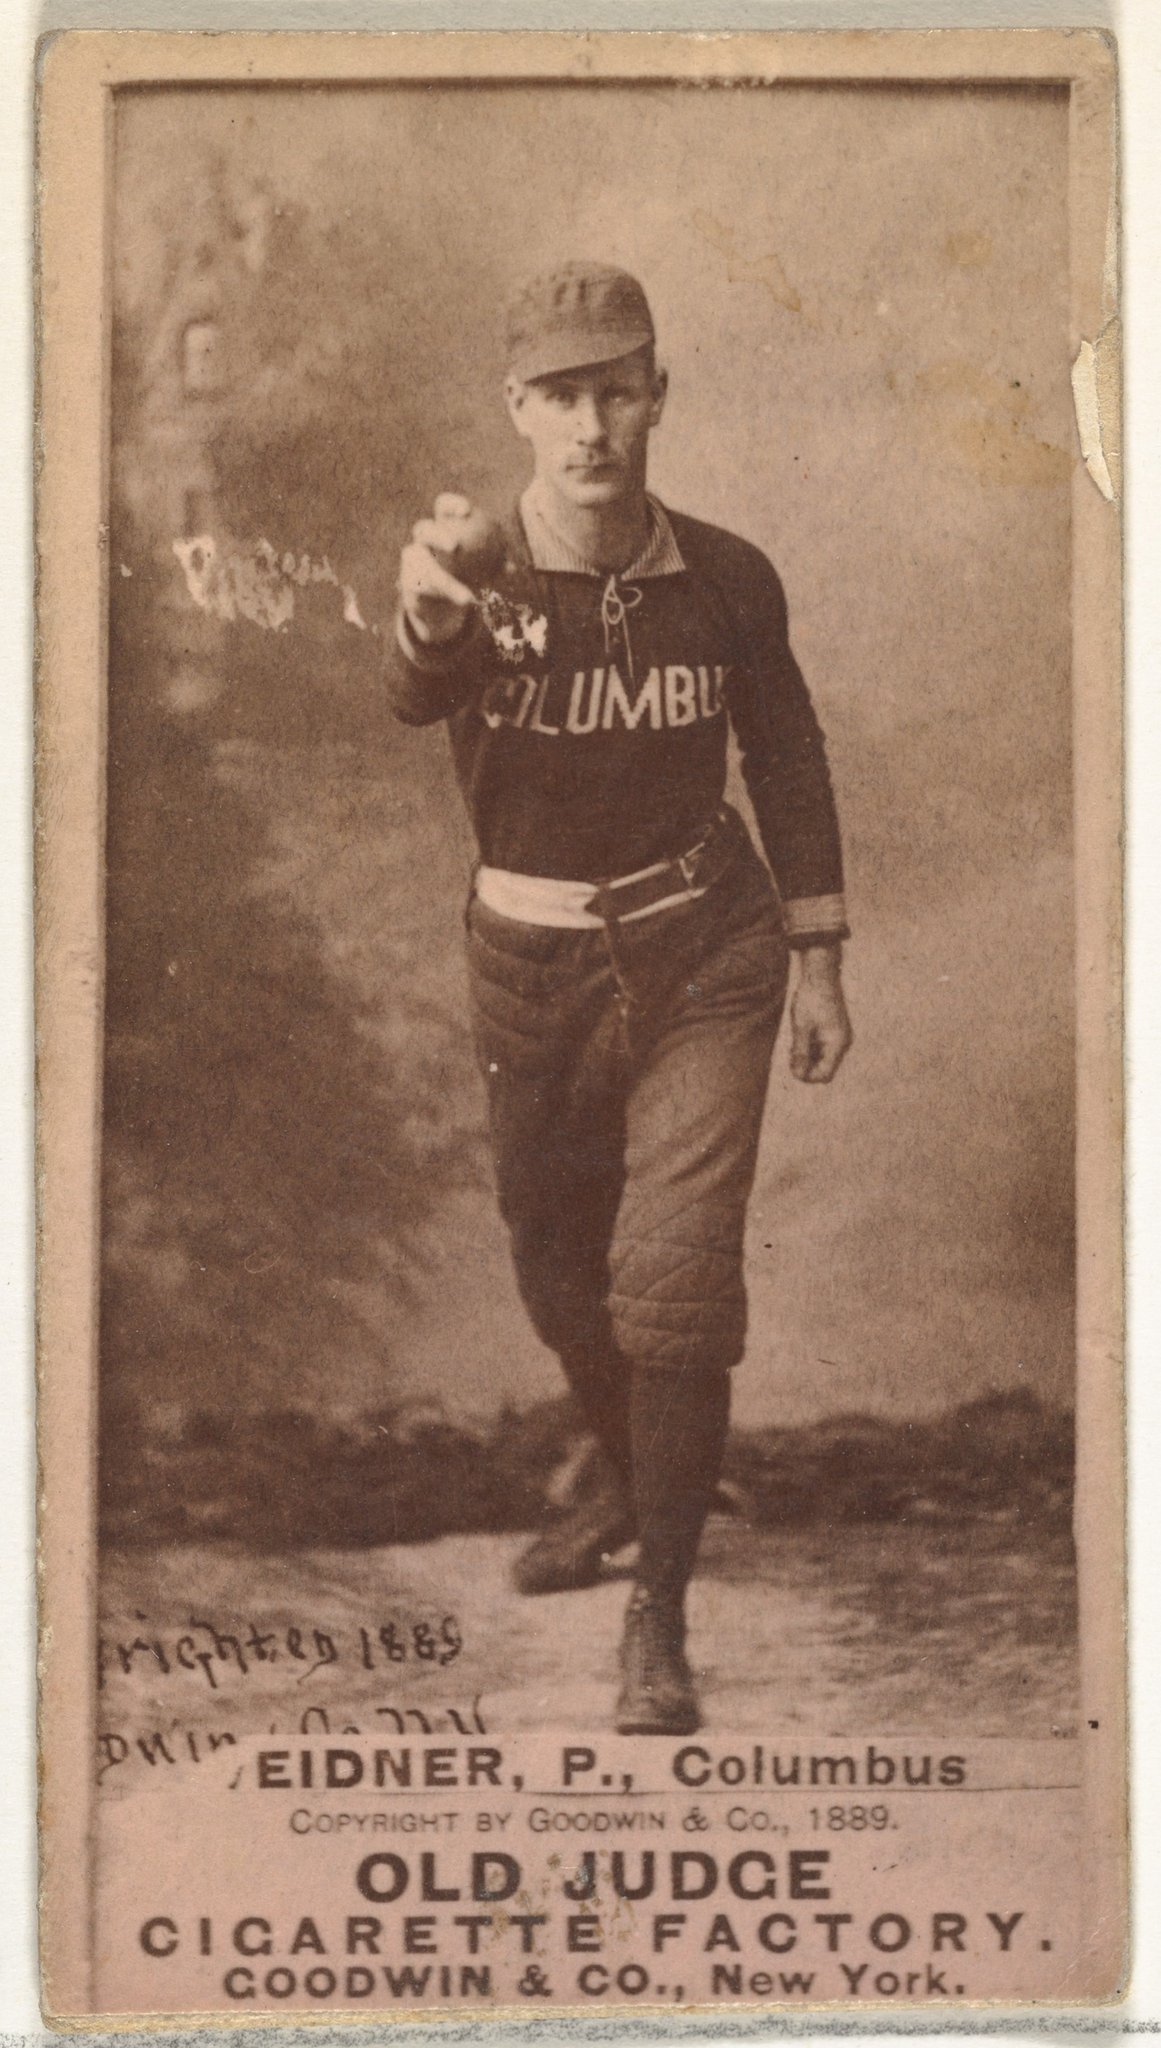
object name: baseball card, photograph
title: William Waterfield "Wild Bill" Widner, Pitcher, Cleveland, from the Old Judge series (N172) for Old Judge Cigarettes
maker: goodwin & company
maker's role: publisher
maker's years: 1850-1950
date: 1889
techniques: albumen silver print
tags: men,portraits,baseball,athletes